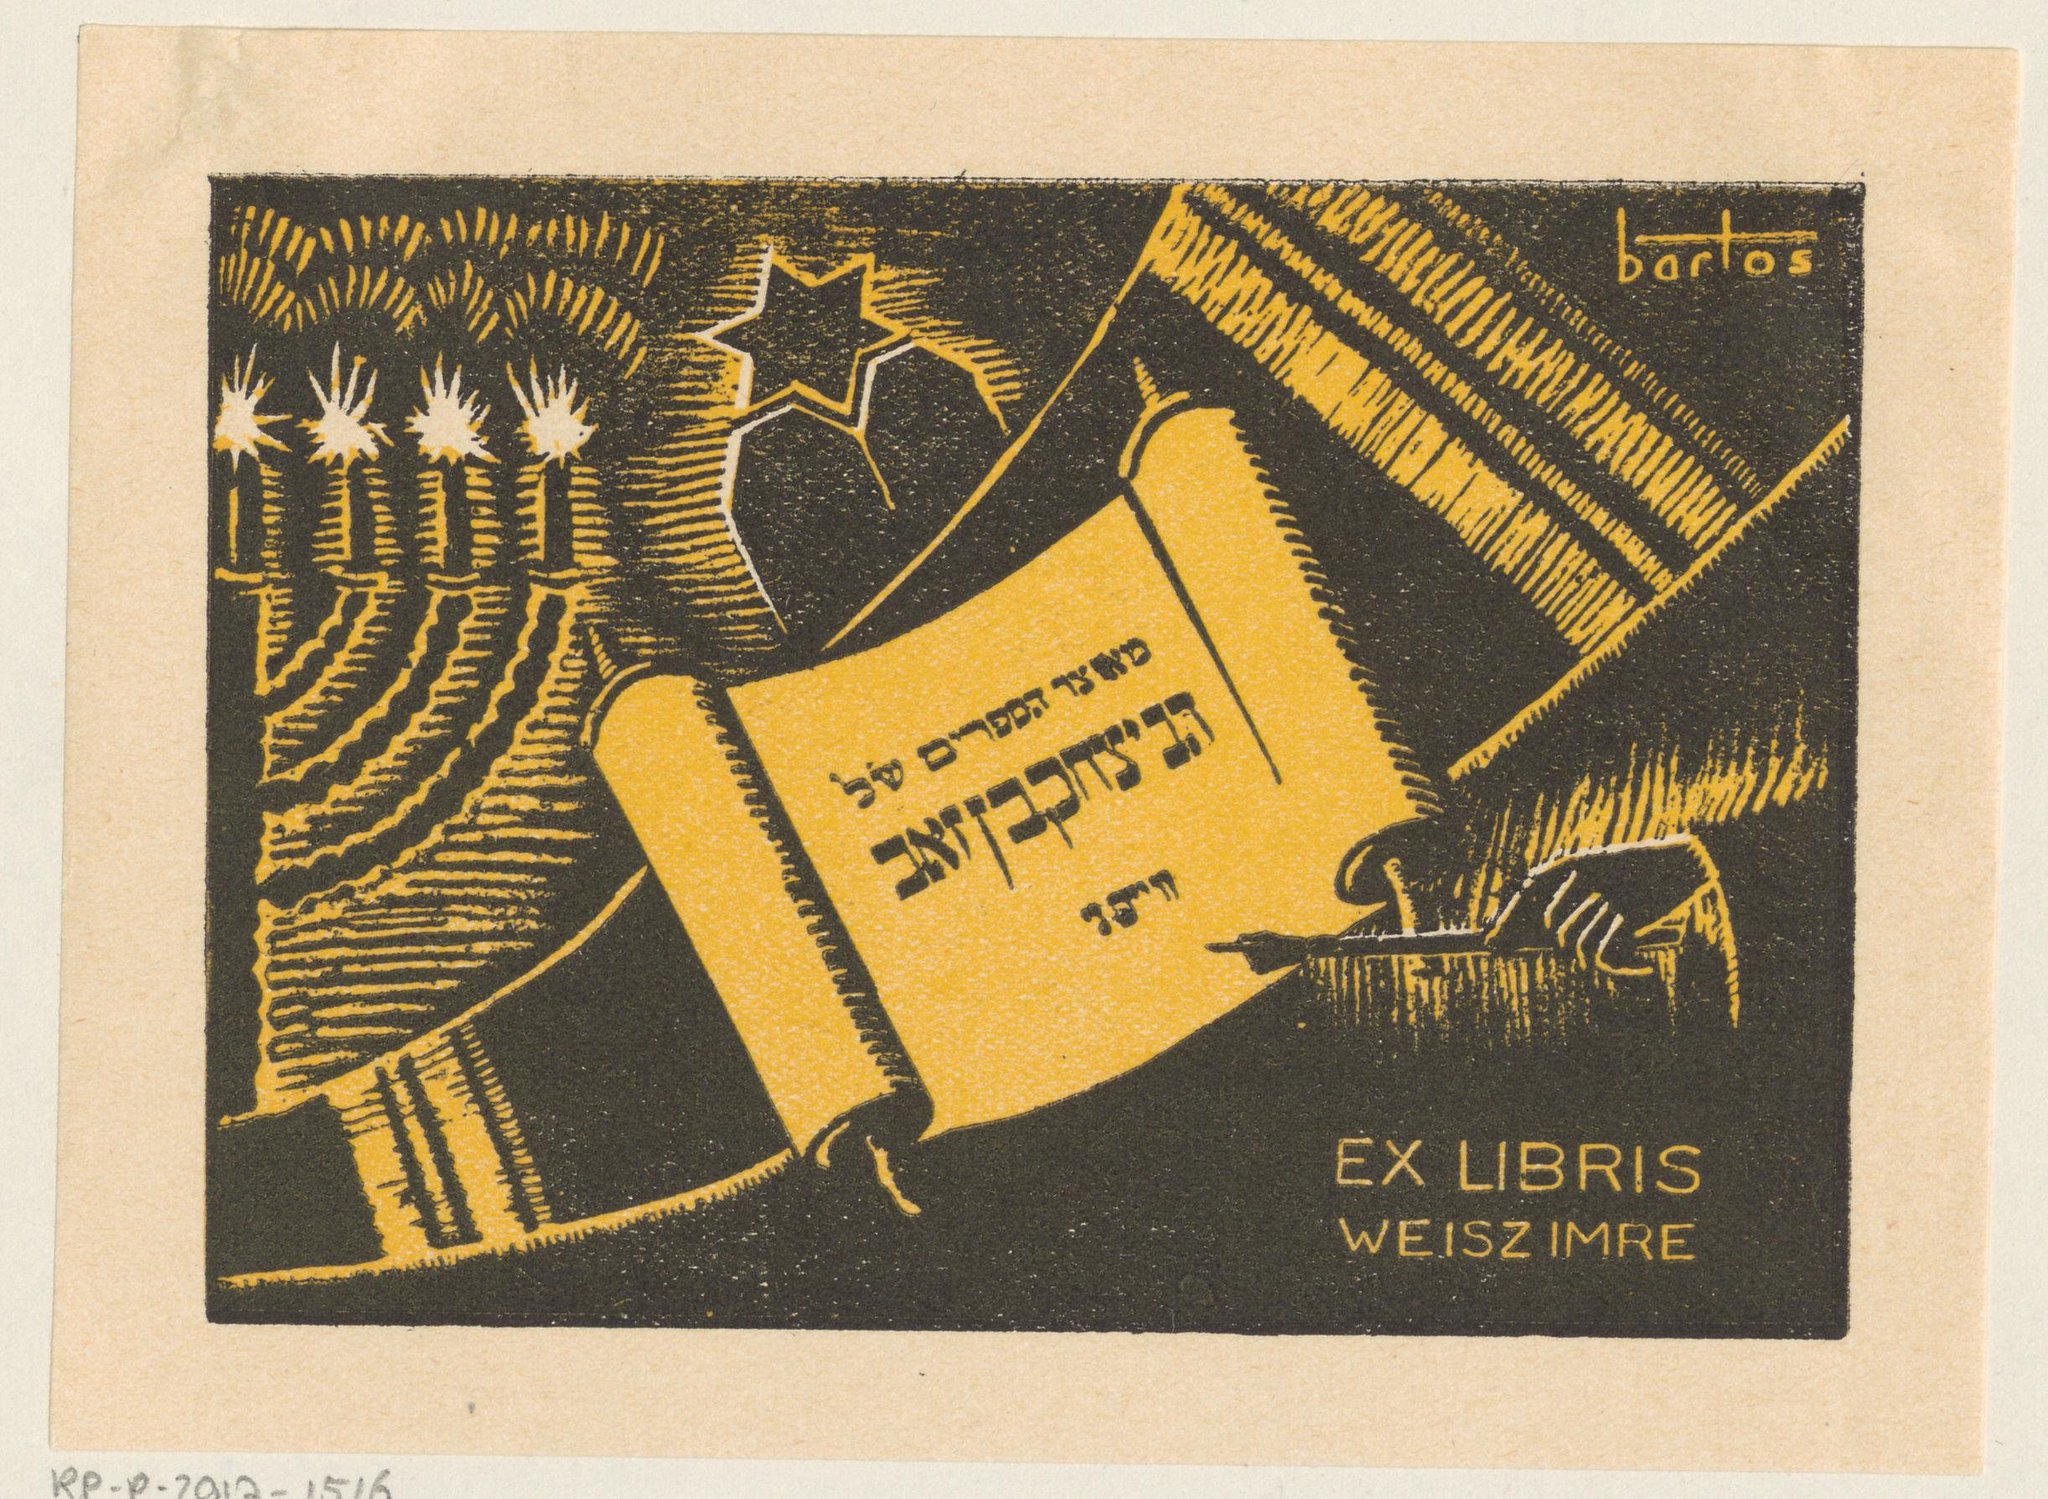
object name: bookplate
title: Ex libris van Imre Weisz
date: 1912-1943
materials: paper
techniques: printing block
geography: hungary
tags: 'menorah', golden seven-branched candlestick, kept in the tabernacle, 'sefer torah', scroll of the law, jewish religion and culture